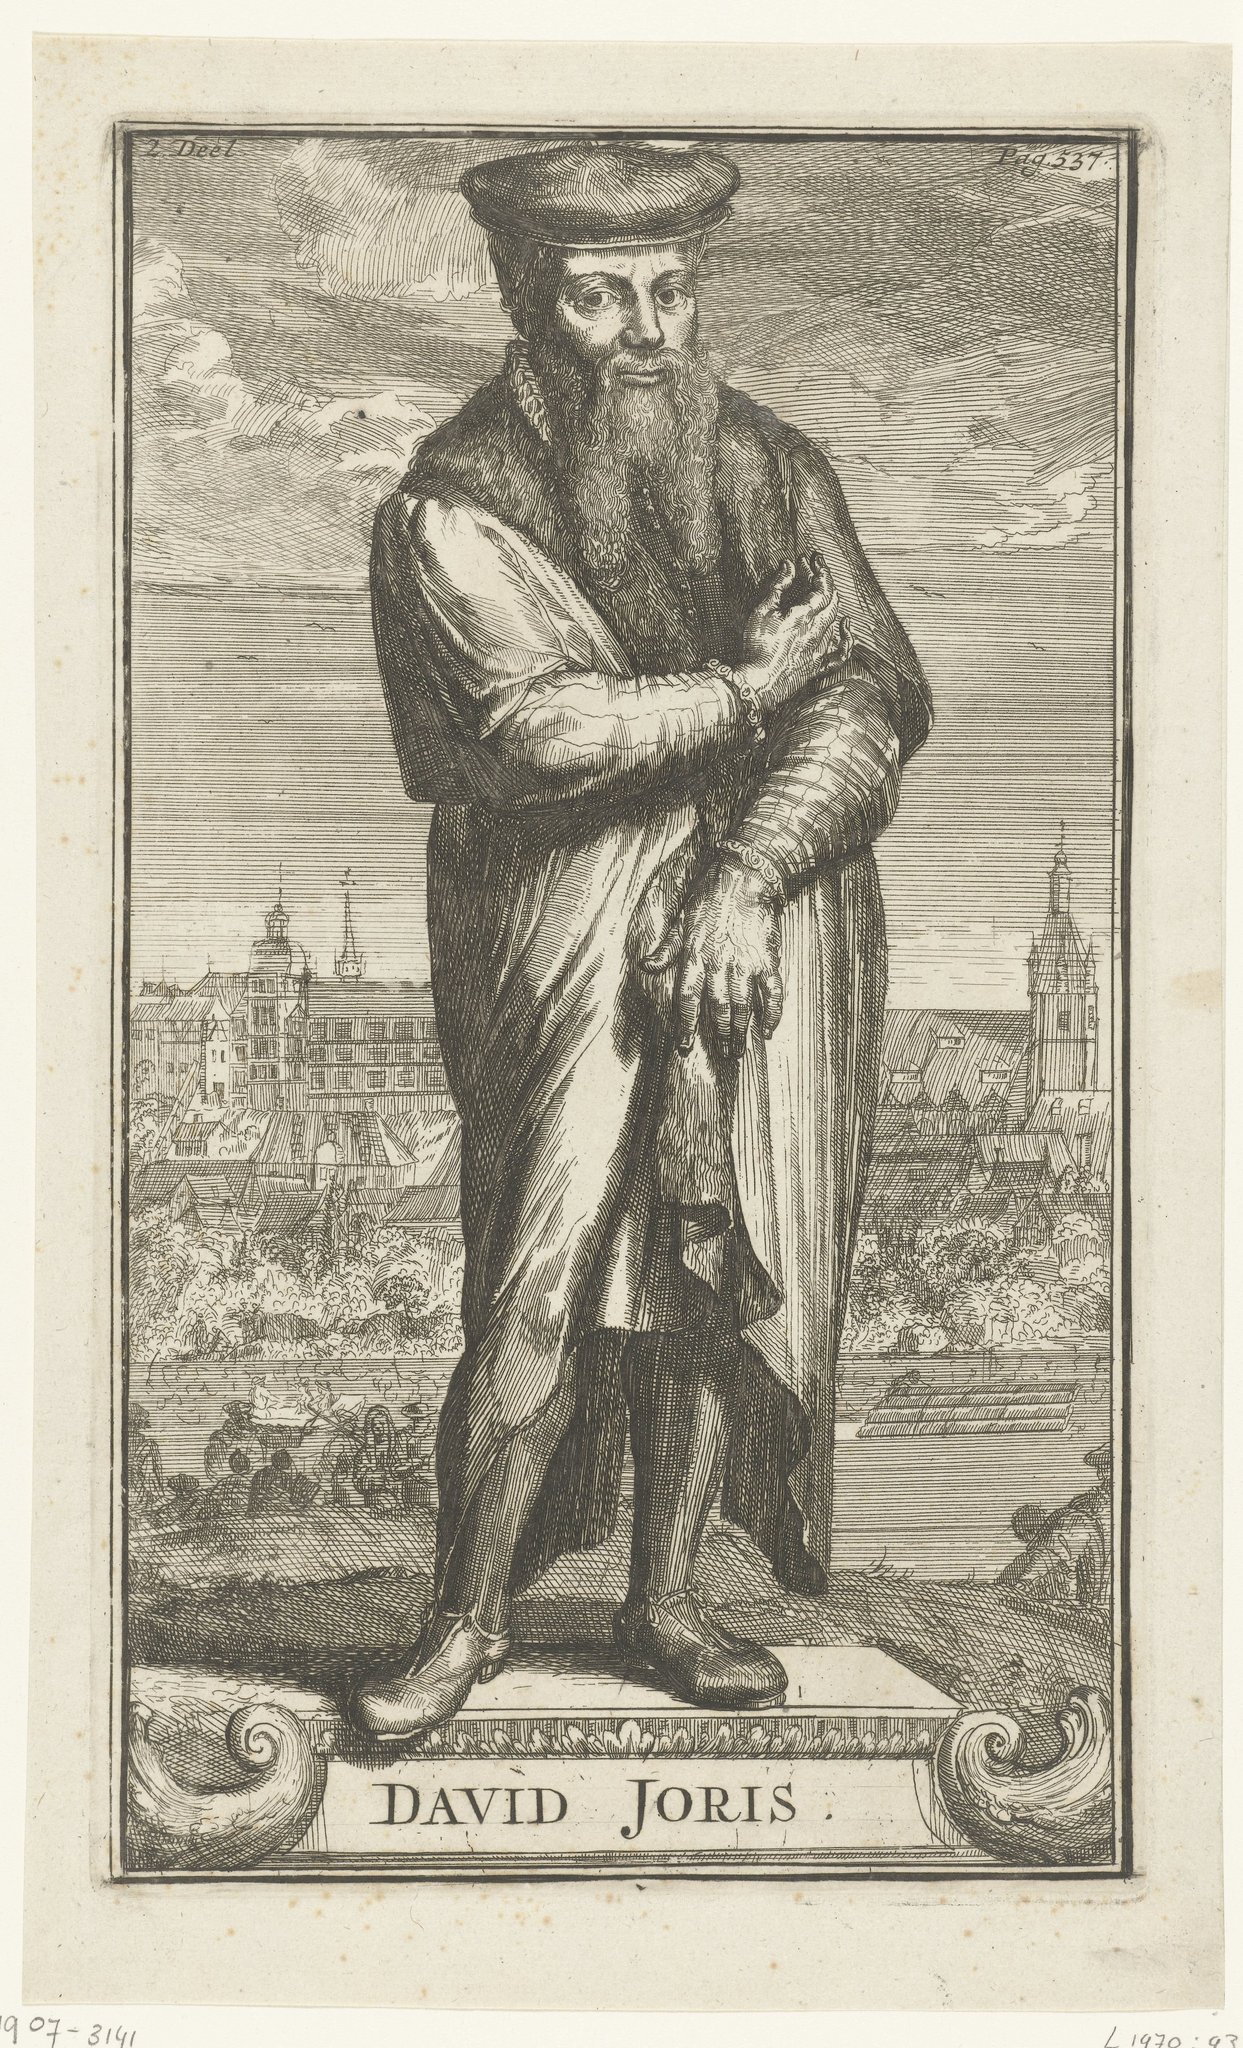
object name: print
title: Portret van David Jorisz.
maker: romeyn de hooghe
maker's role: draughtsman, goldsmith, painter, print maker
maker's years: 1645-1708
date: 1701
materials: paper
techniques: engraving, etching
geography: netherlands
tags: bruges, david jorisz.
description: Portret van David Joris uit een serie van 28 portretten in het tweede deel van Historie der Kerken en ketteren van den beginne des Nieuwen Testaments tot aan het jaar onses Heeren 1688 van Godfried Arnold (1701).